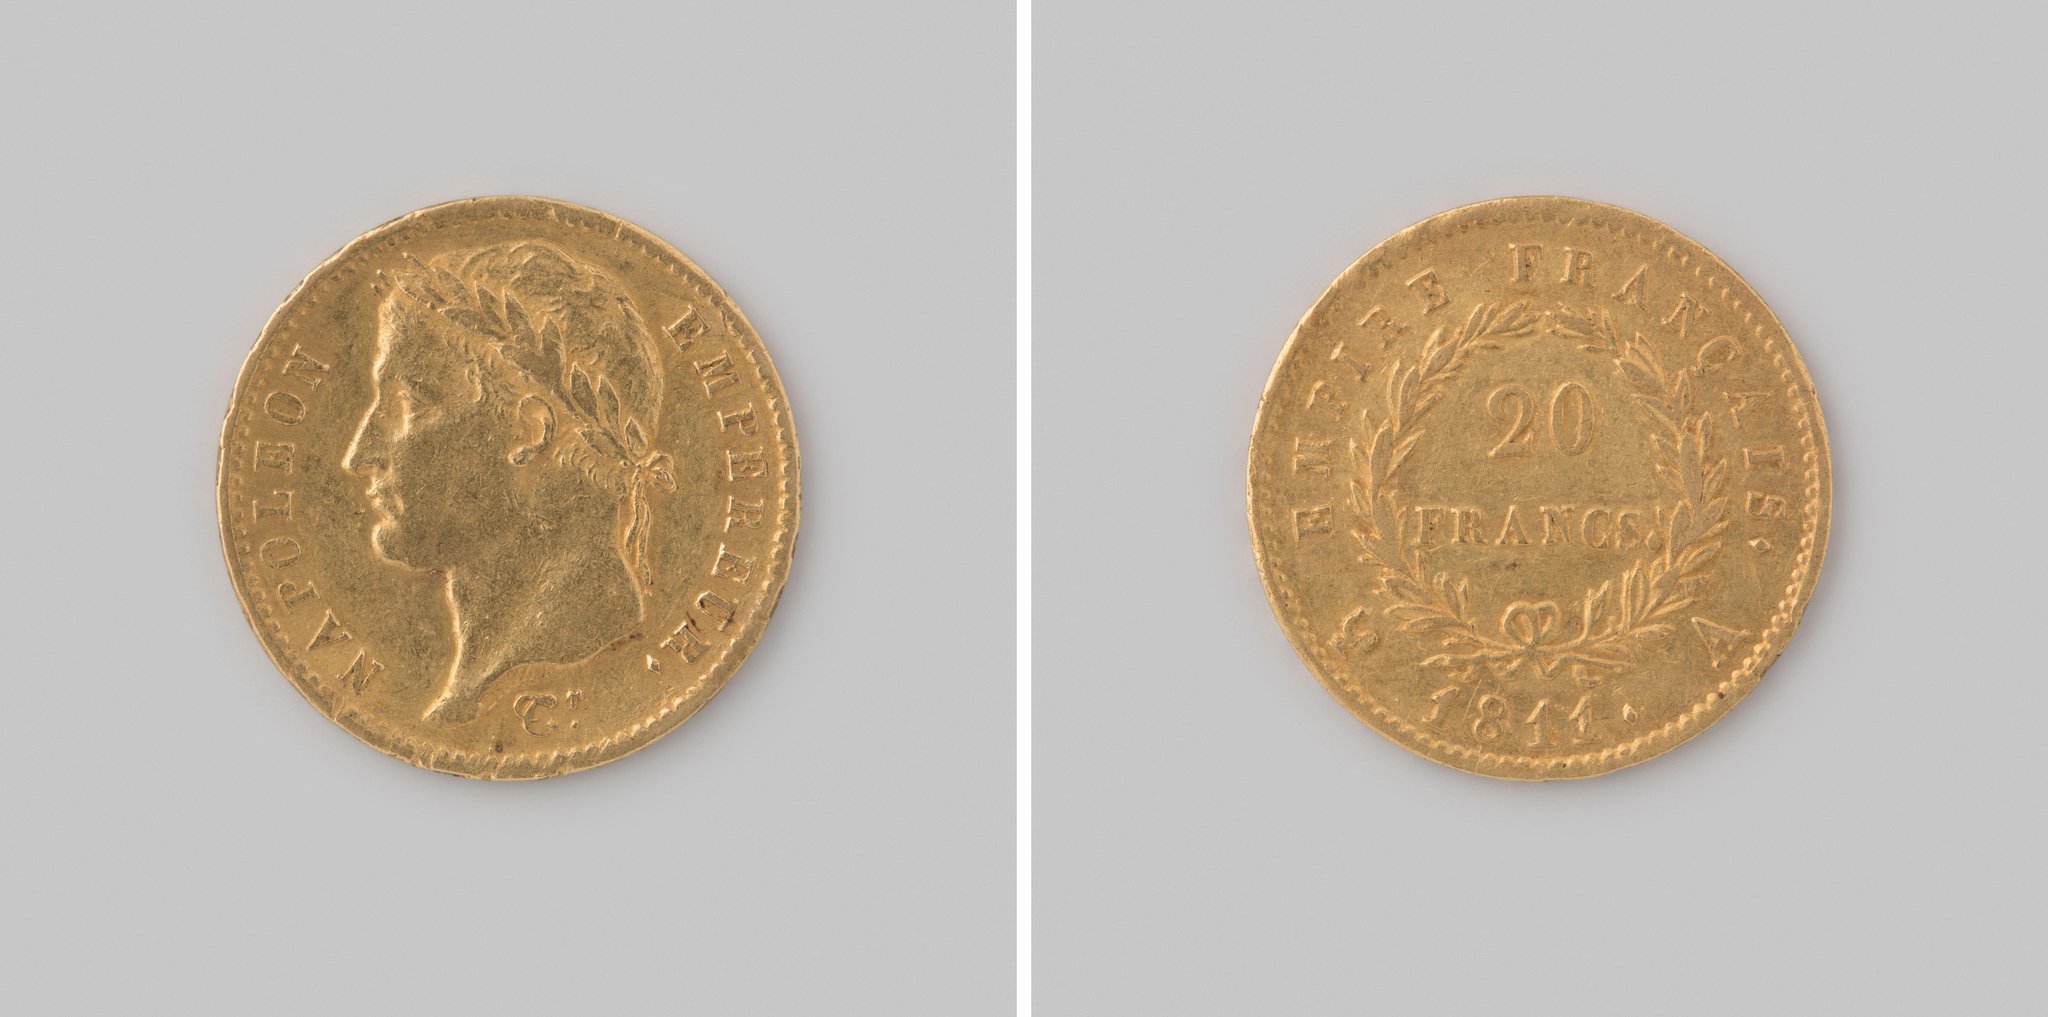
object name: coin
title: Twintig francs uit het keizerrijk Frankrijk van Napoleon, 1811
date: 1811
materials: gold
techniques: striking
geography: paris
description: Gouden munt. Voorzijde: gelauwerd borstbeeld van de keizer naar links. Keerzijde: binnen twee samengebonden lauriertakken waarde-aanduiding in twee regels. Omschrift: Empire Francais. Onderaan jaartal. Rechts daarvan letter A [=Parijs]. Randschrift.